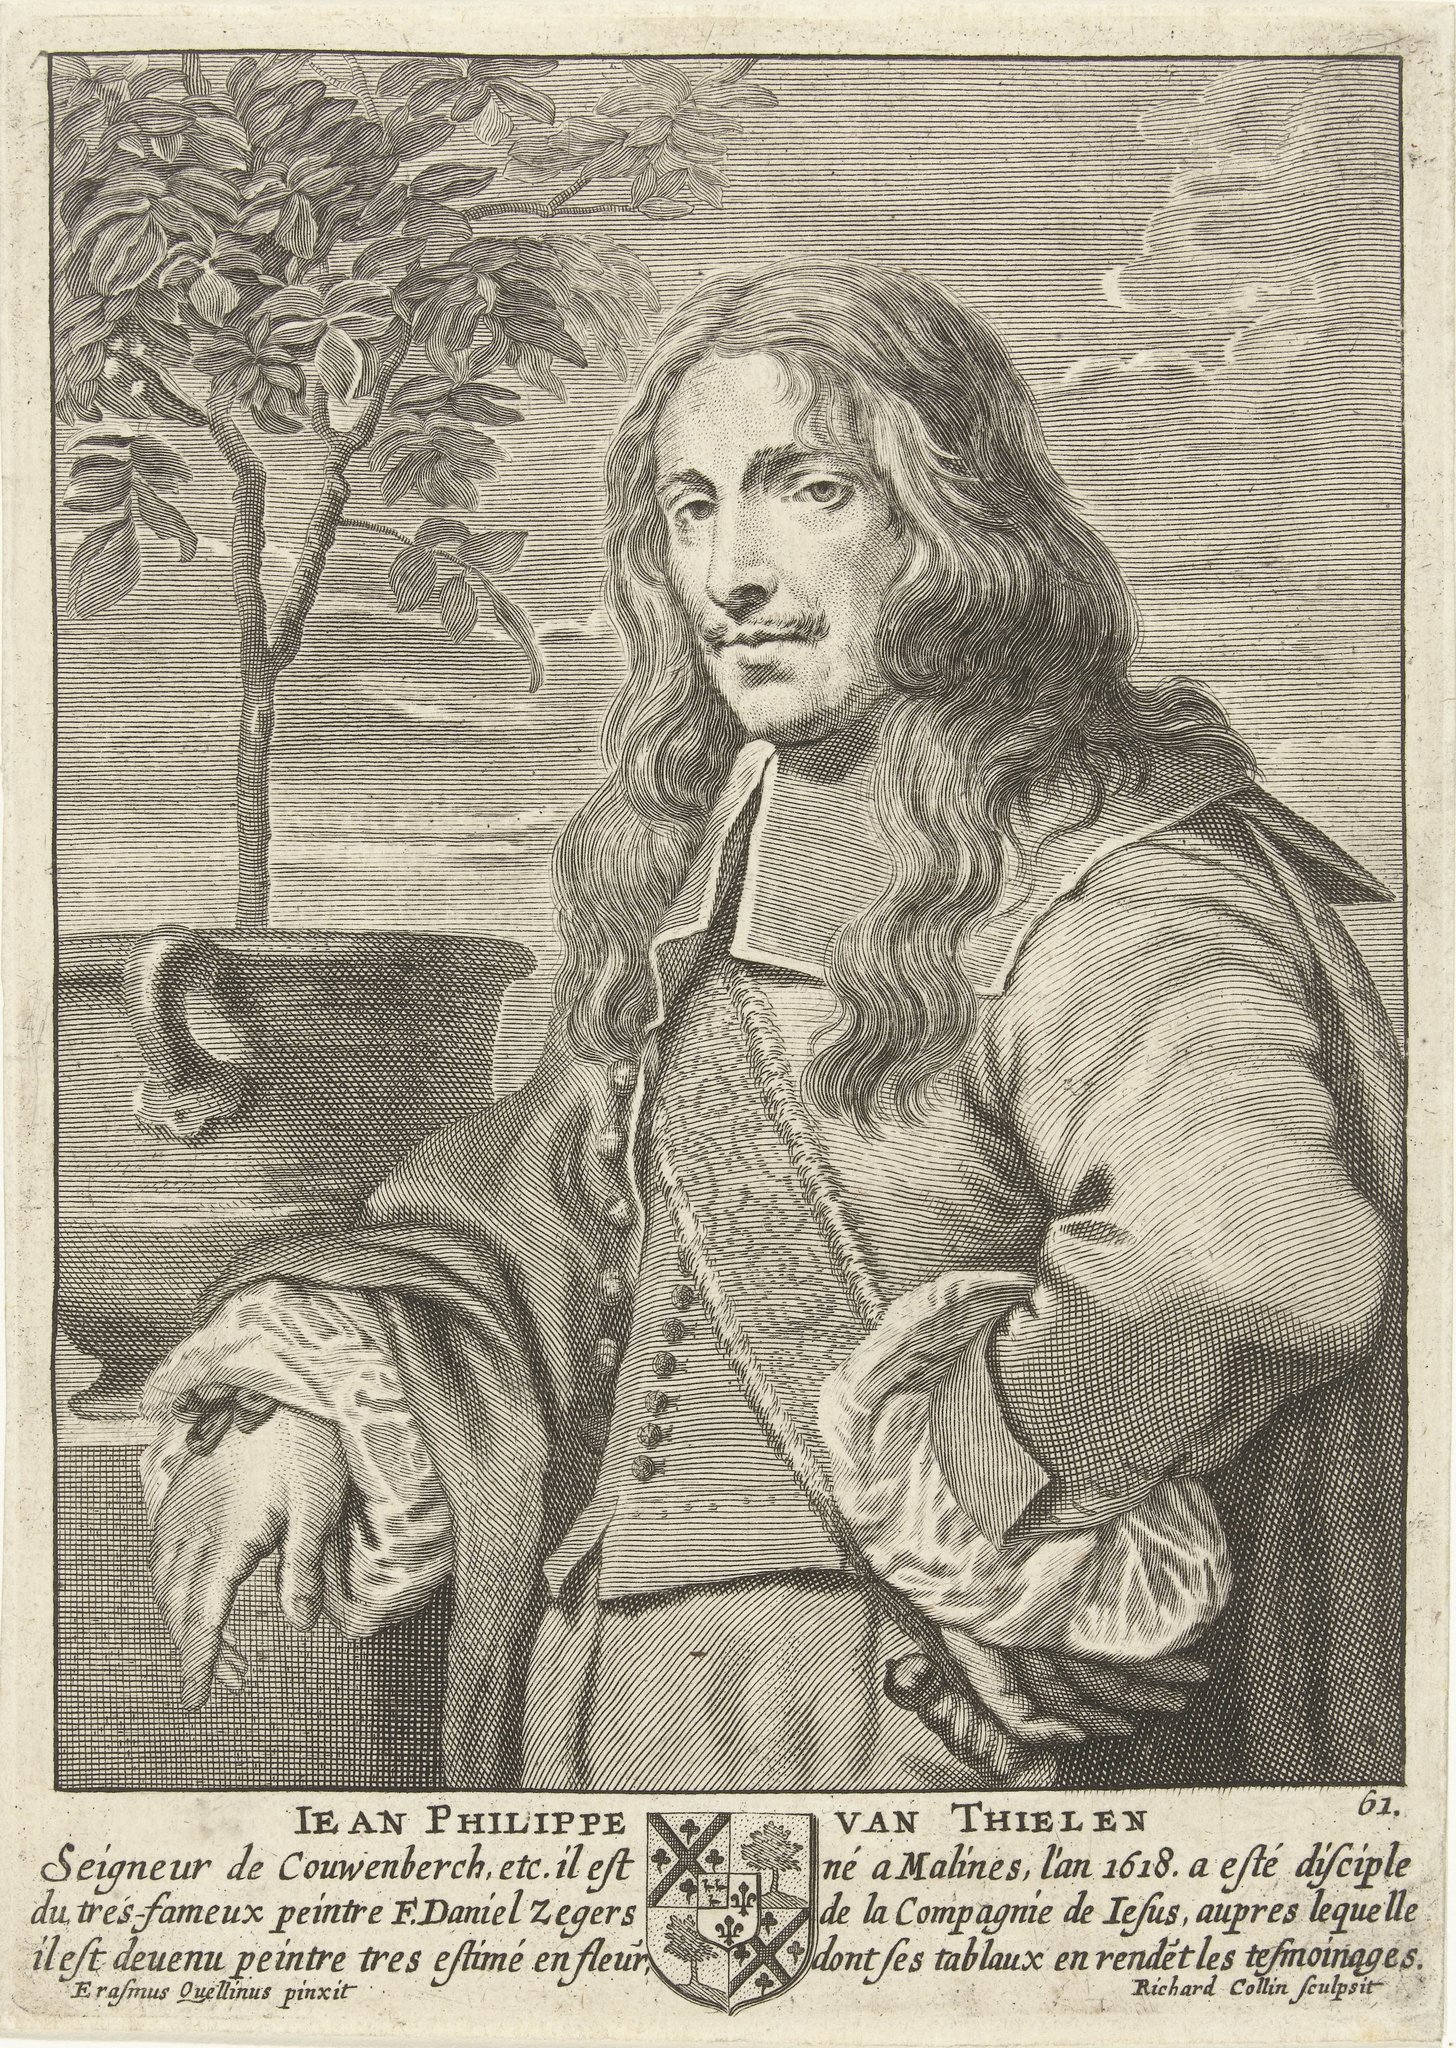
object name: book illustration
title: Portret van Jan Philip van Thielen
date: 1649-1662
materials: paper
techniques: engraving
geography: antwerp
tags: mechelen, painter, jan philip van thielen, historical persons, portrait, self-portrait of painter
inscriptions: collector's mark: Lugt 2228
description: Huidige staat van prent (genummerd 61) gebruikt in: The Portraits of the Most Eminent Painters, and other Famous Artists (...). Londen: Olive Payne, 1739. Eerste bekende staat (ongenummerd) gebruikt in: Bie, Cornelis De. Het gulden Cabinet vande edel vry schilder const, inhoudende den lof vande vermarste schilders, architecte, beldthowers ende plaetsnyders van dese eeuw. Antwerpen: Joannes Meyssens, 1662 [1661 foutief op titelpagina], p. 345. En mogelijk ook al in: Meyssens, Joannes. Image de divers hommes desprit sublime qui par leur art et science deburovent vivre eternellement et des quels la louange et renommée faict estonner le monde. 2 dln. Antwerpen: Joannes Meyssens, 1649. Tweede bekende staat (genummerd 82) gebruikt in: Resta, Sebastiano. The true effigies of the most eminent painters and other famous artists that have flourished in Europe. Londen, 1694.